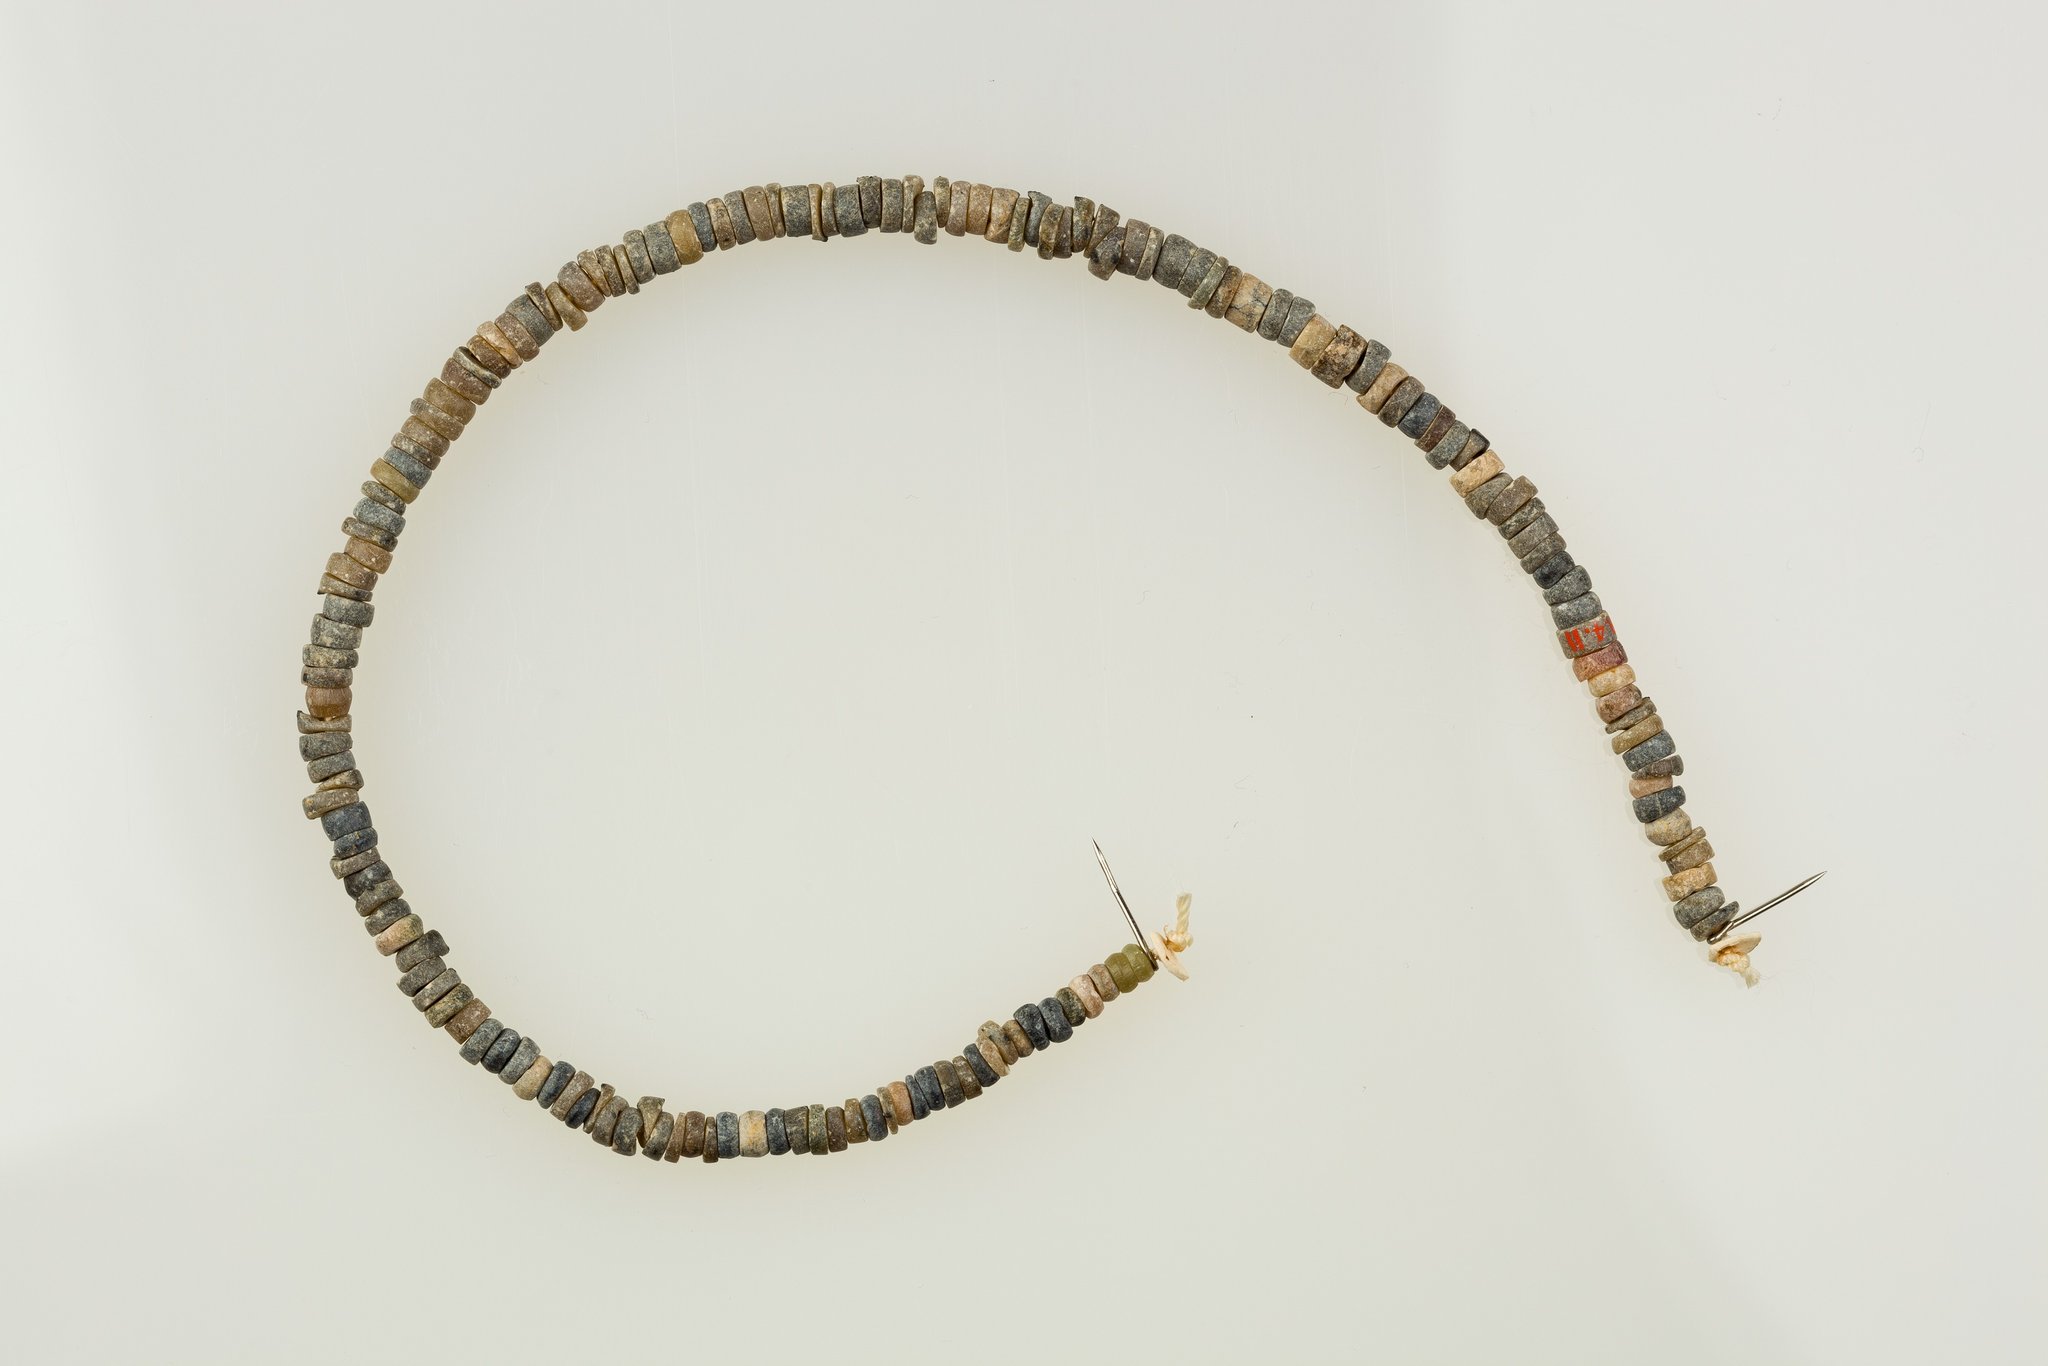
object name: bead, string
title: String of beads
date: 3650-2960 BCE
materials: stone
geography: egypt